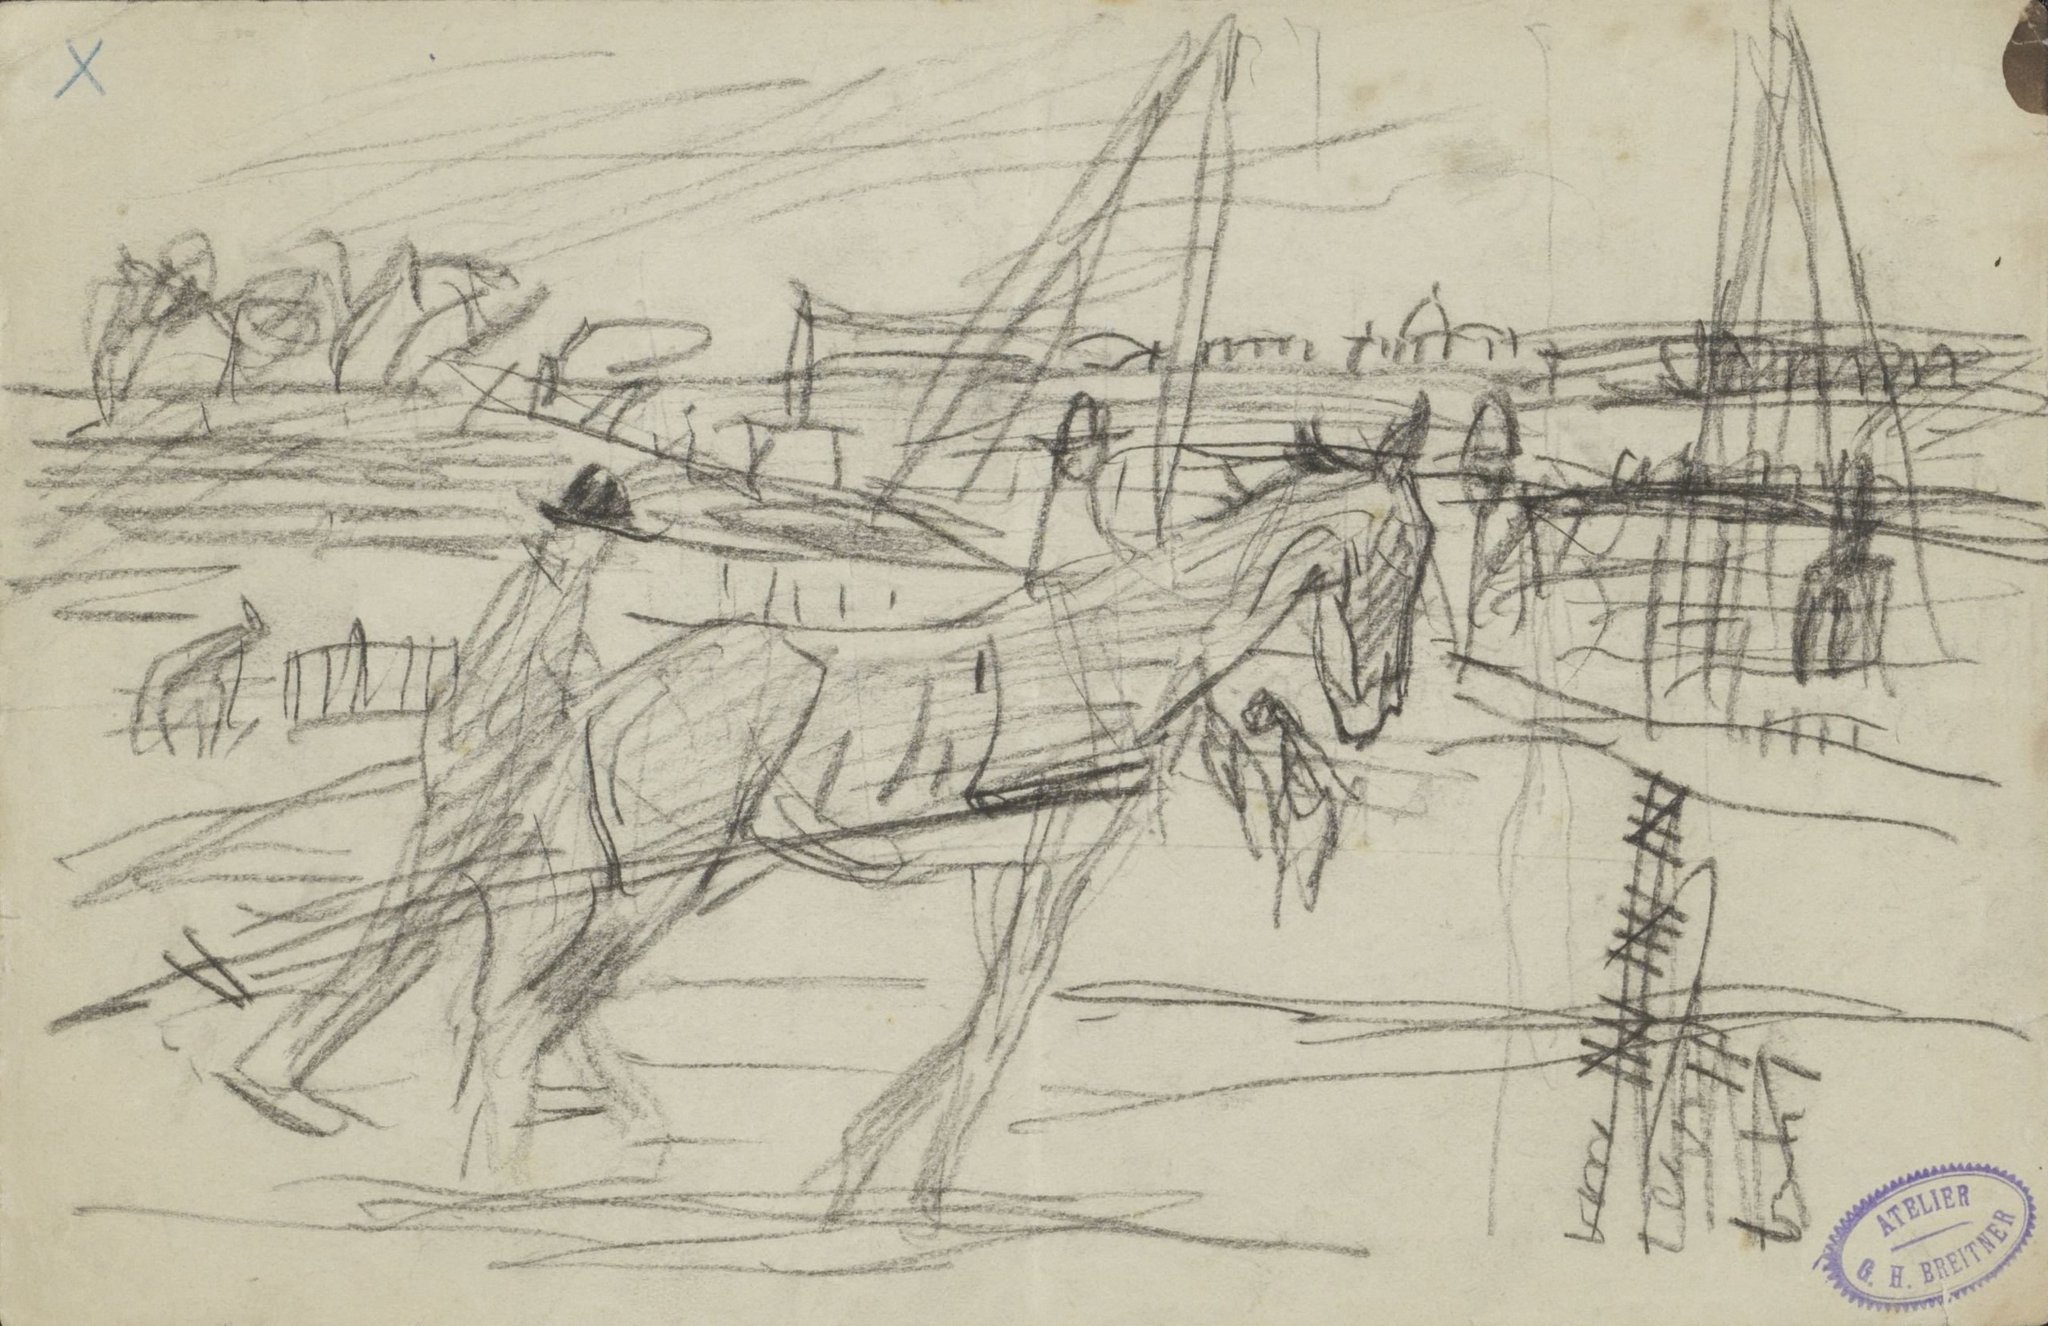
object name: drawing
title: Sleperspaard en arbeiders op een bouwterrein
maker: george hendrik breitner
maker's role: draughtsman, painter, print maker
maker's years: 1857-1923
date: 1897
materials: chalk, paper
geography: amsterdam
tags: harbour, building-site (+ men (labourers)), horse, amsterdam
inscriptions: annotation, workshop stamp: Lugt 291d